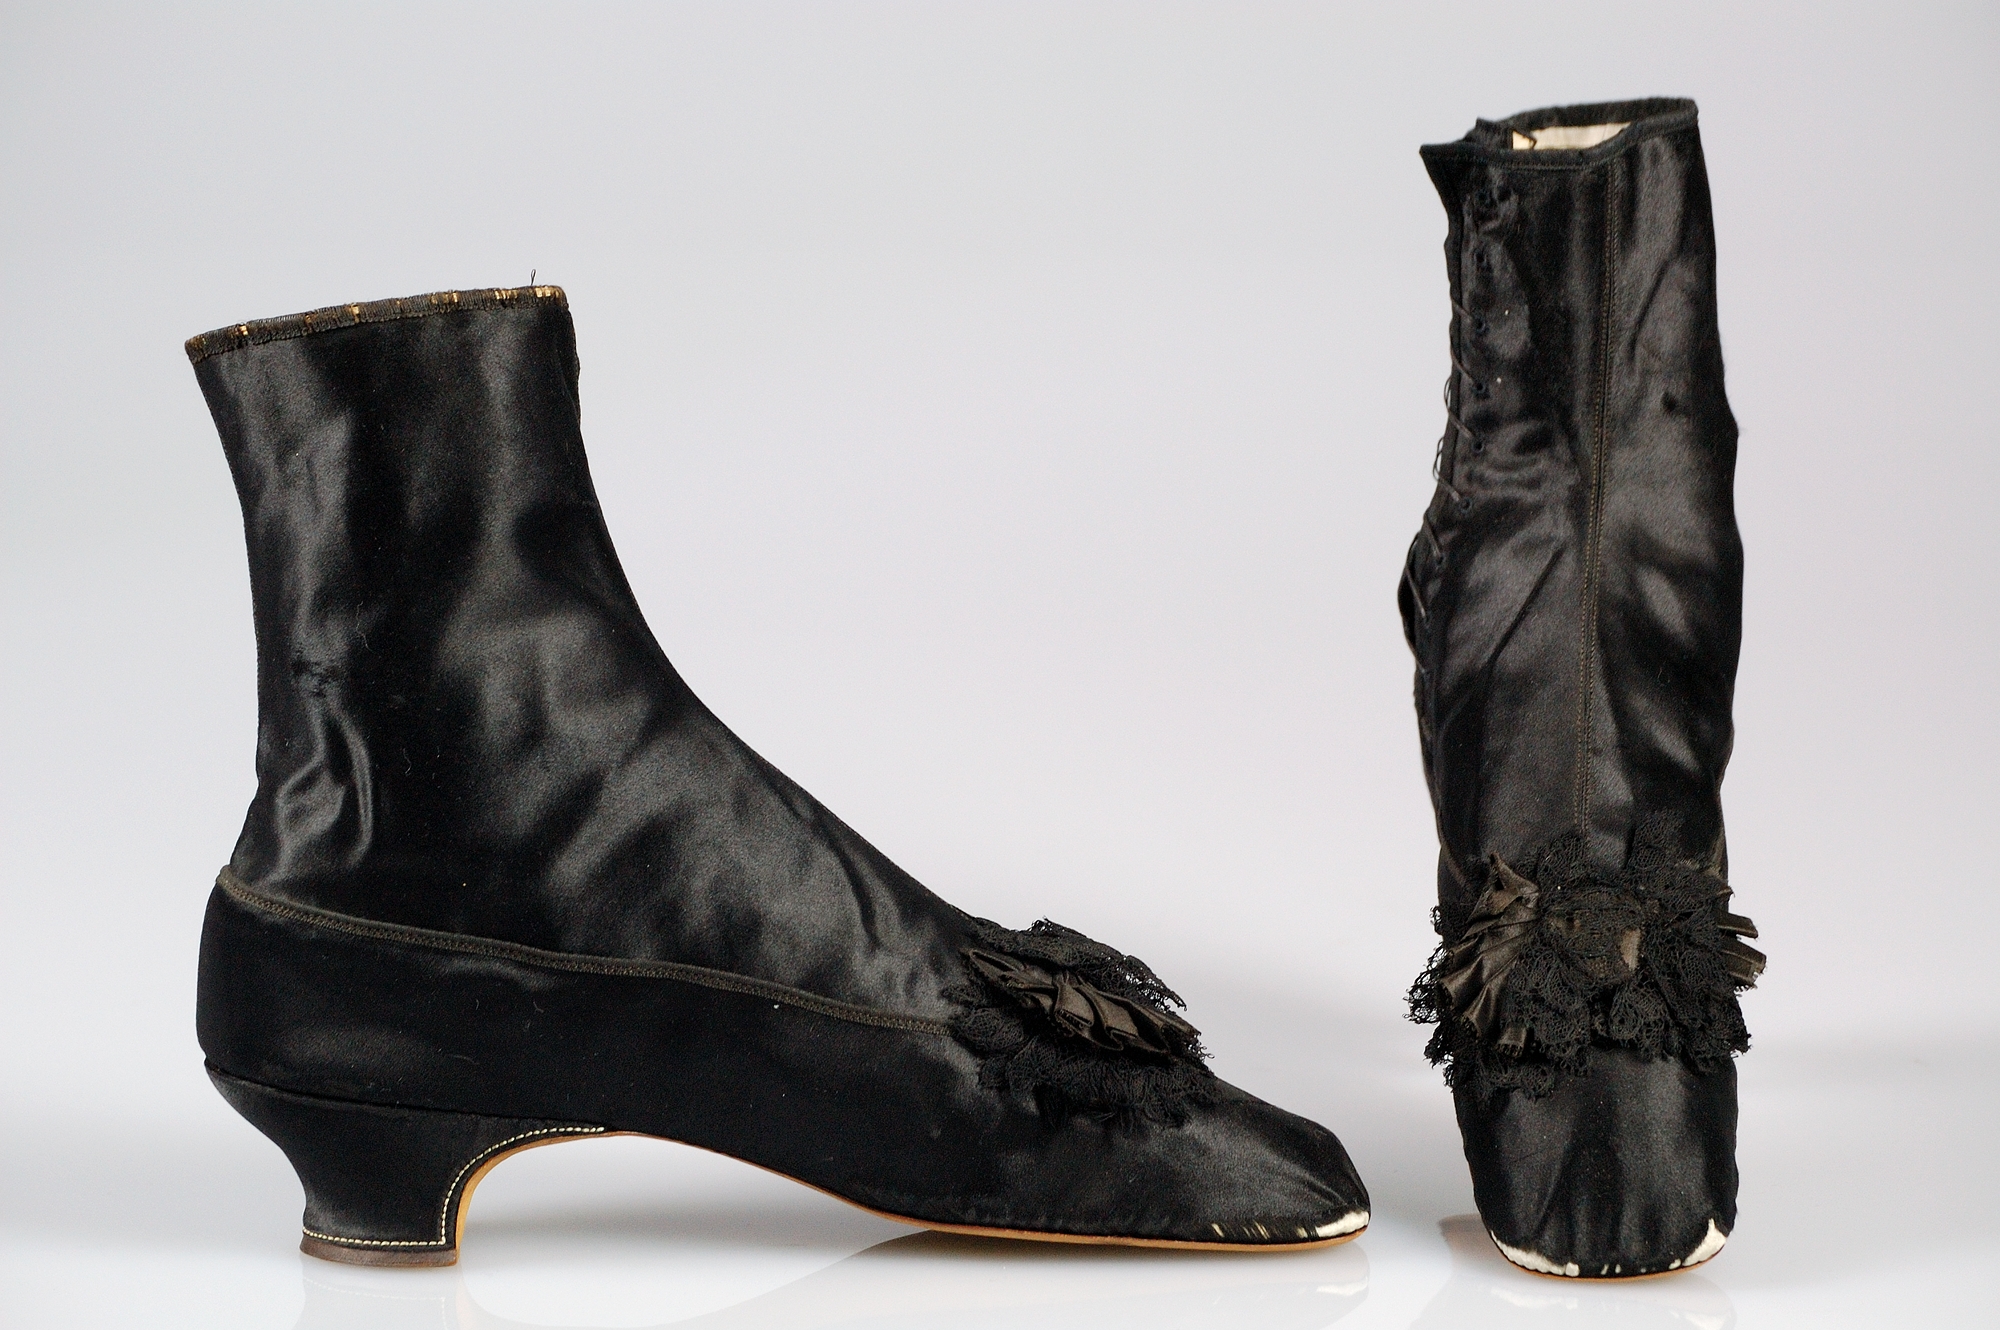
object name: evening boot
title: Evening boots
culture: french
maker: defossée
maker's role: maker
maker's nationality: french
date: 1855-1865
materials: silk